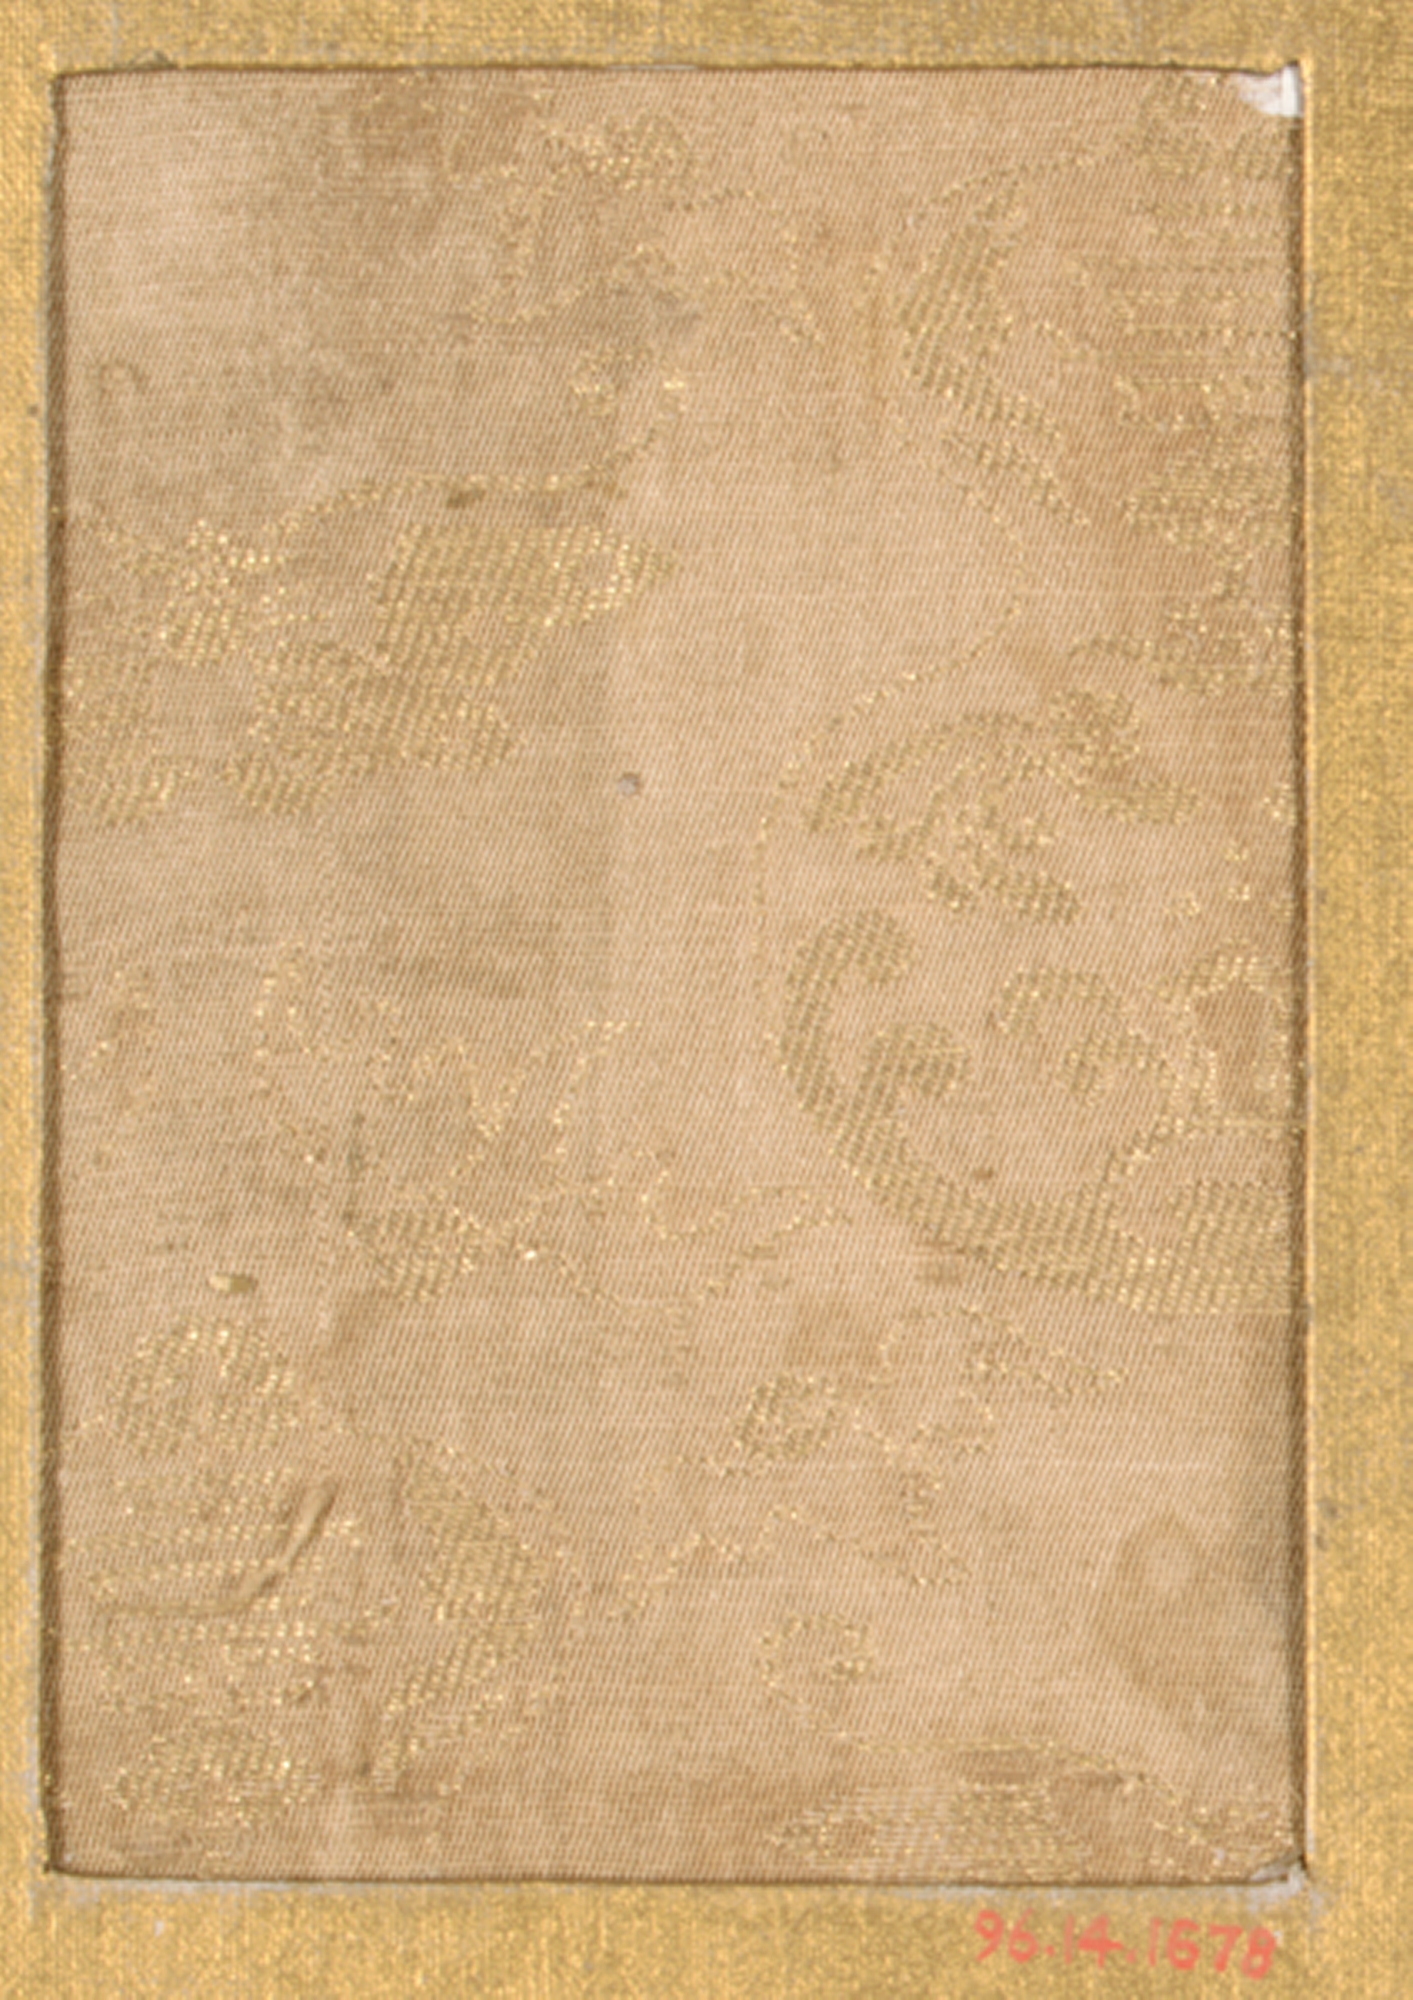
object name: piece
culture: japanese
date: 1701-1900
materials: silk